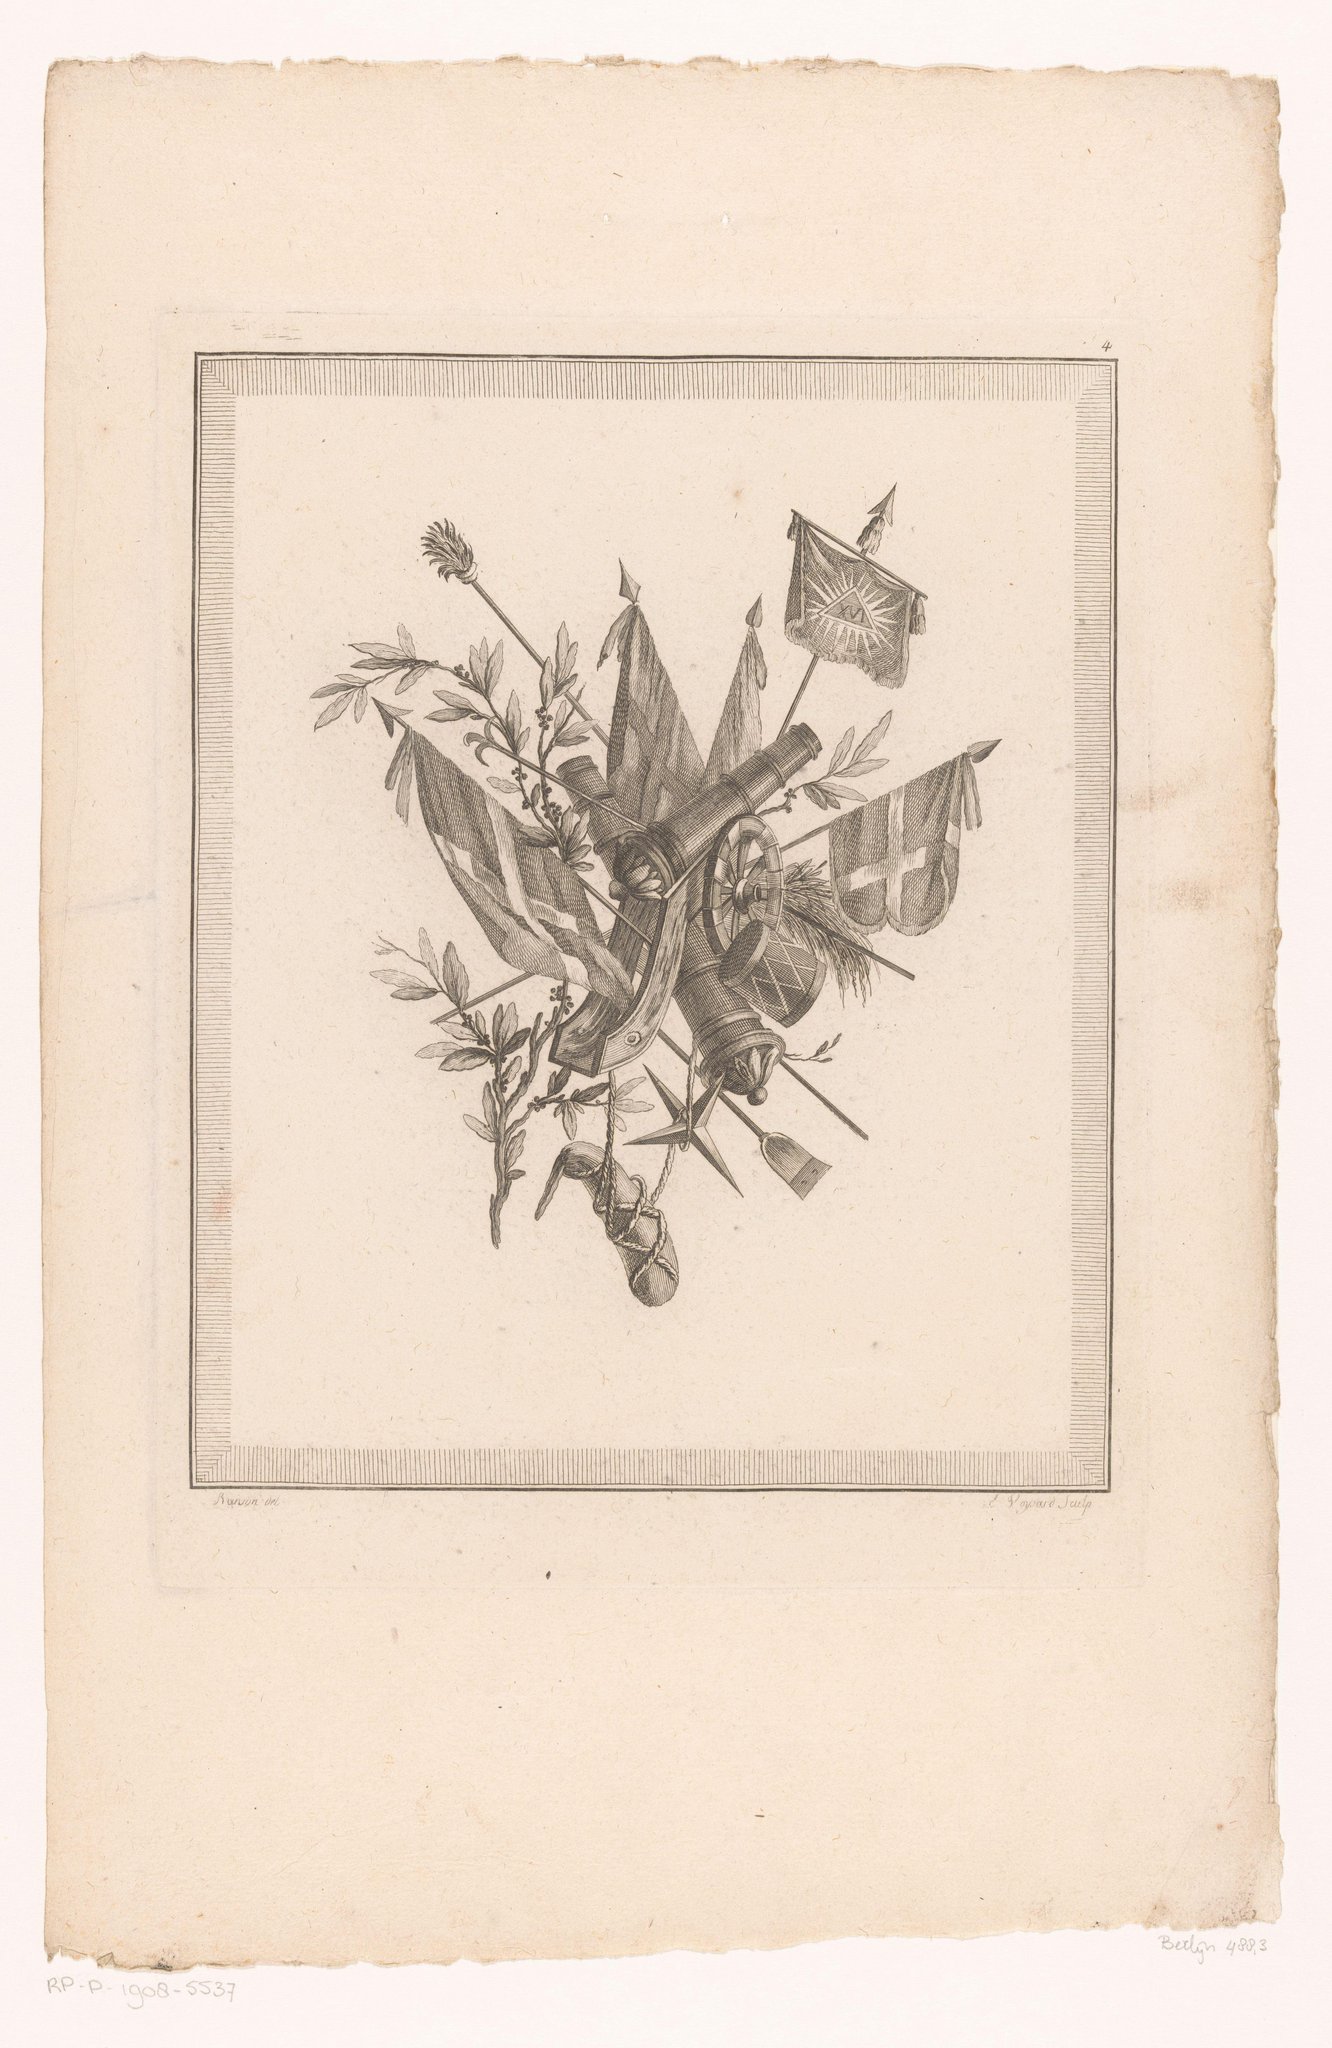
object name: ornament print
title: Wapentrofee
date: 1778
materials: paper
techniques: etching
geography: paris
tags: 'tropaion', i.e. decorative ornament ~ weapons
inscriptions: collector's mark: Lugt 2228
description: Een wapentrofee met vlaggen en kanonnen.